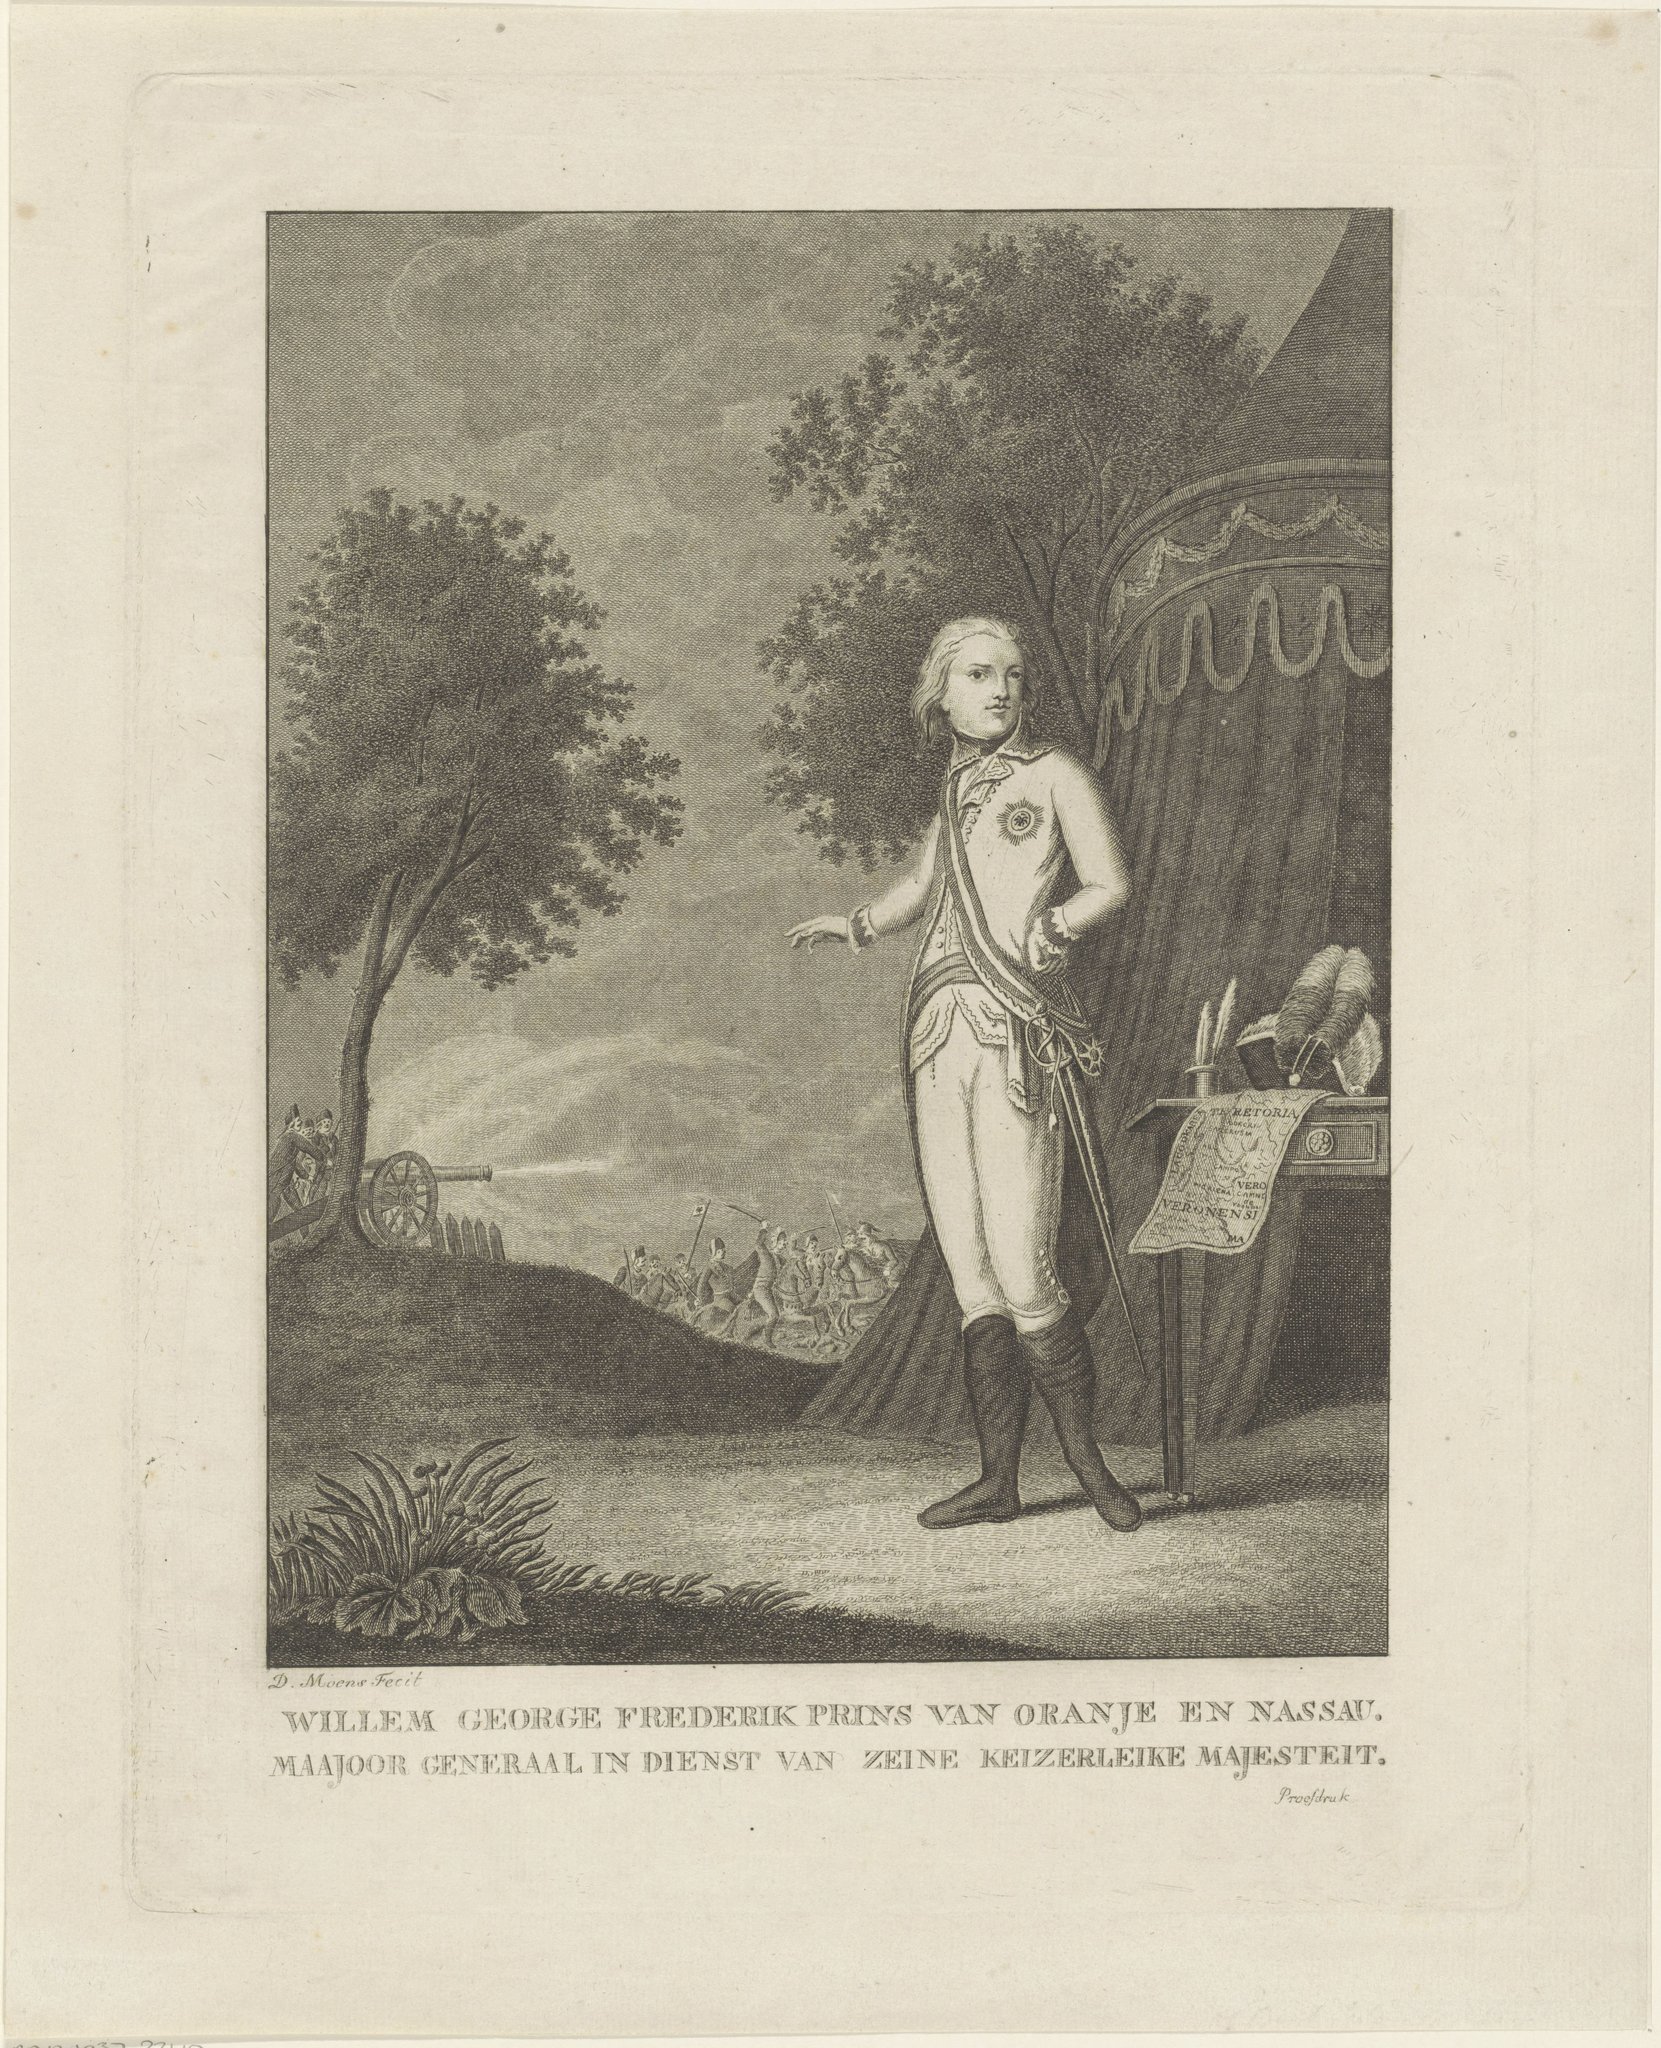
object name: print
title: Portret van Frederik, prins van Oranje-Nassau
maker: david moens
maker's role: print maker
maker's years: 1757-1832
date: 1790-1832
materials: paper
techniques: engraving, etching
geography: rotterdam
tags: the hague, willem george frederik (prins van oranje-nassau), knighthood order (with name) - insignia of a knighthood order, e.g.: badge, chain (with name of order)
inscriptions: collector's mark: Lugt 2228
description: De hier vermelde titel verwijst naar de hoogst verkregen titel van de geportretteerde, niet per se naar de titel die de geportretteerde op deze voorstelling draagt.